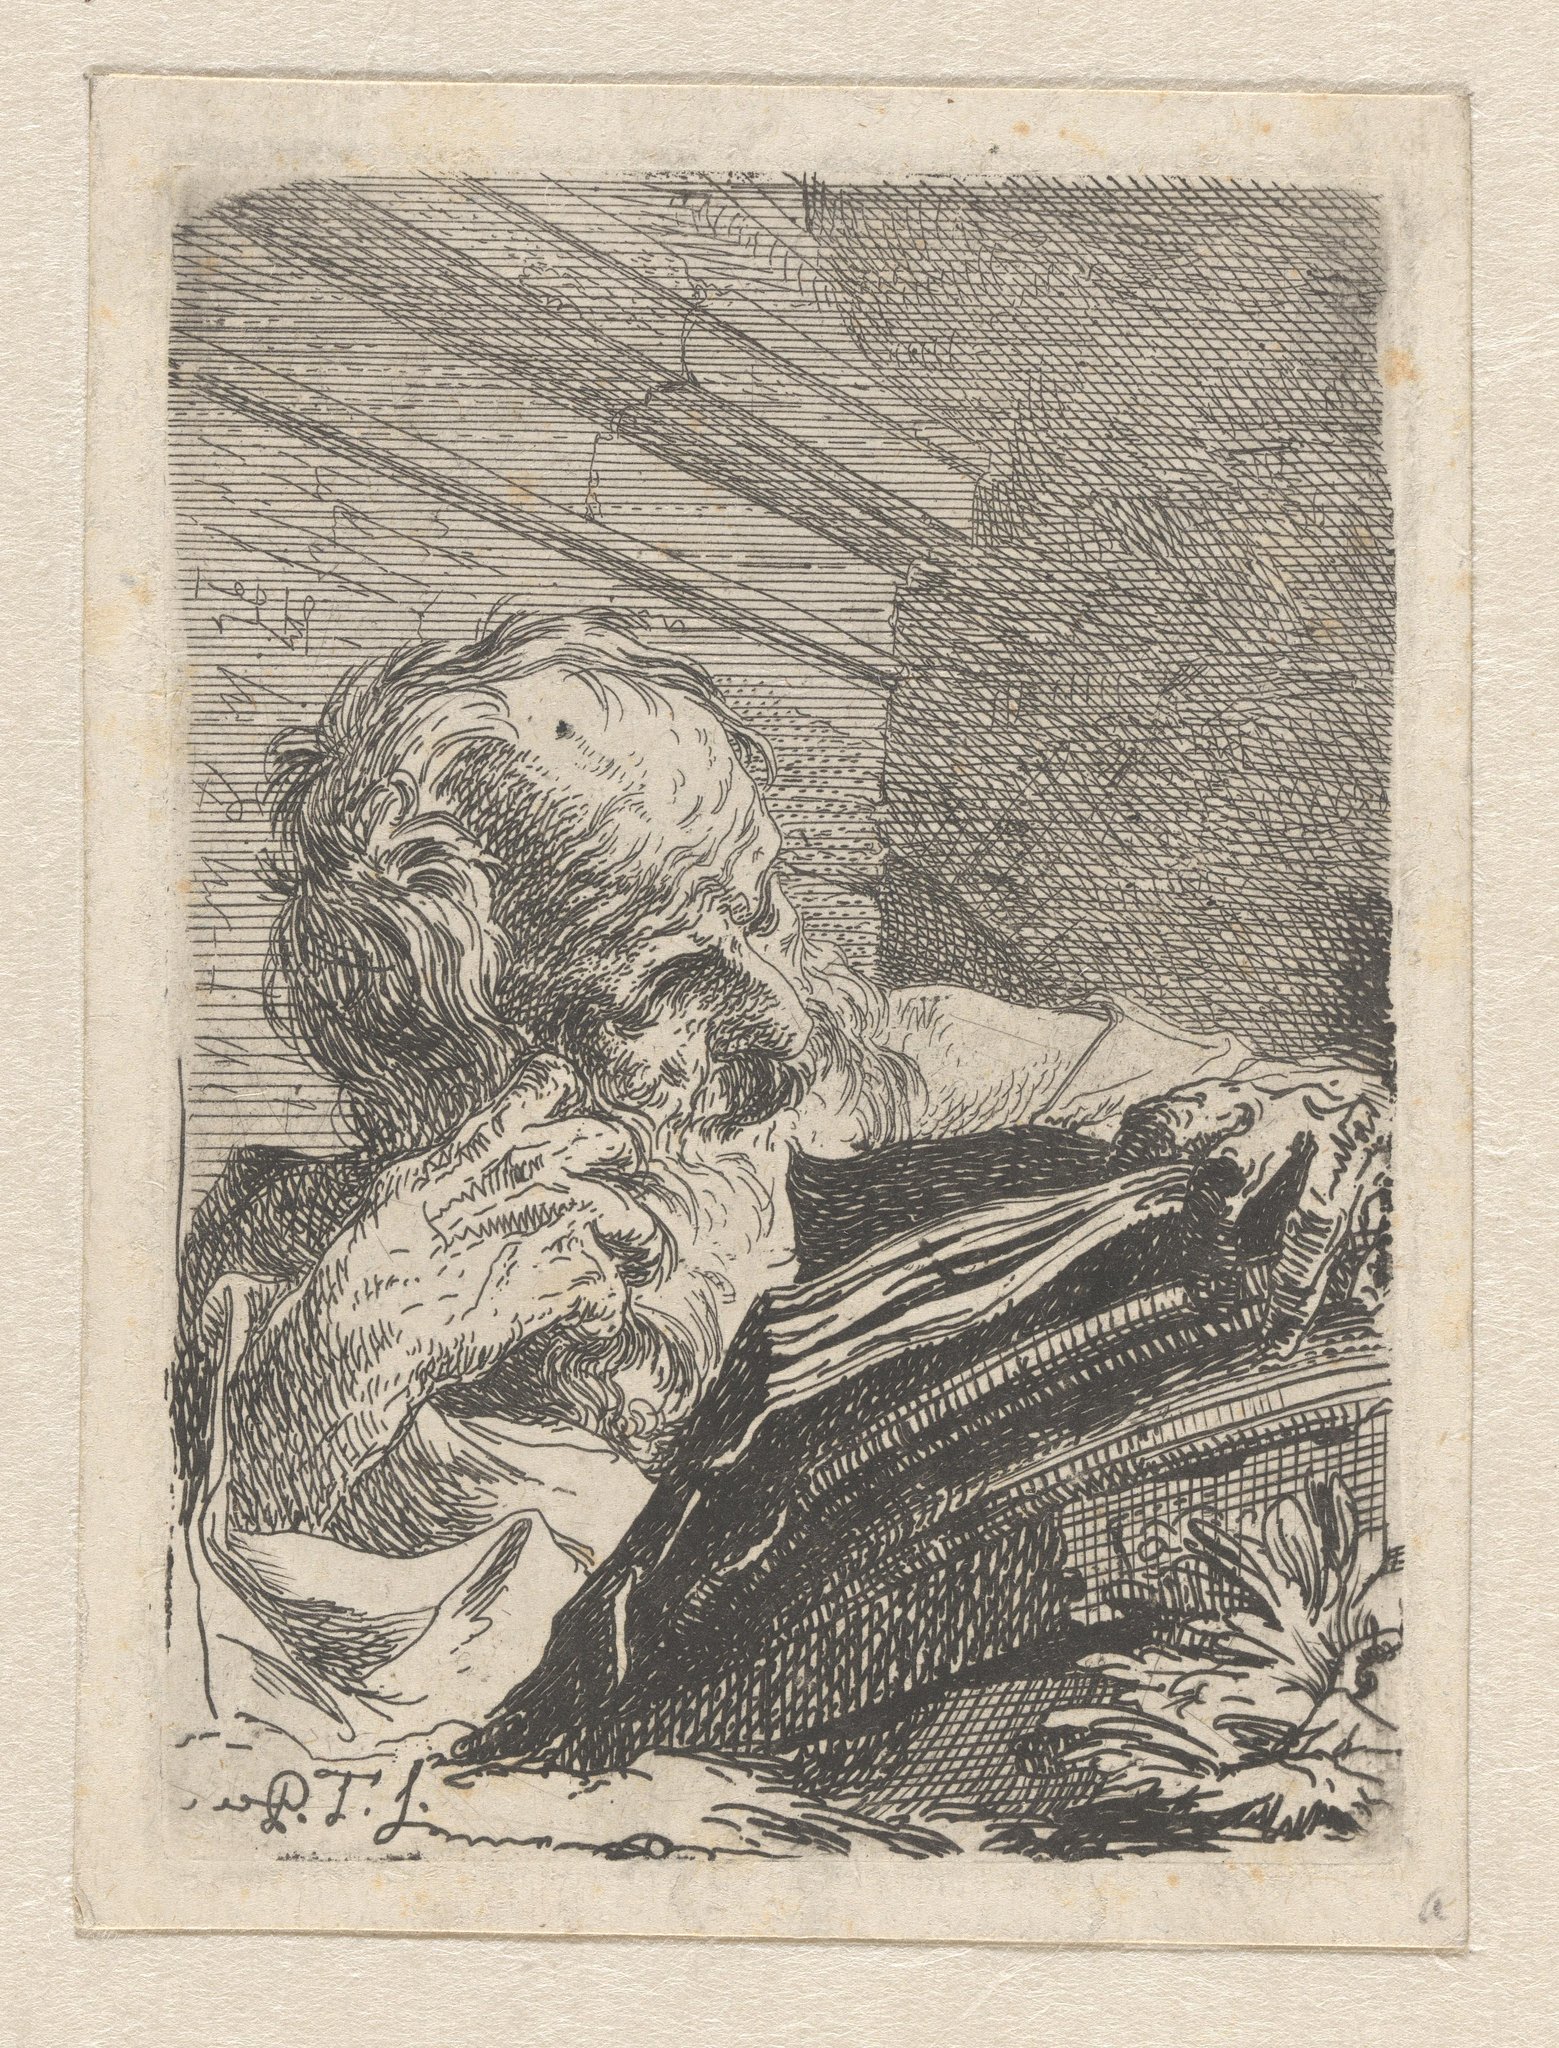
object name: print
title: Buste van een lezende filosoof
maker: paul troger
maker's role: print maker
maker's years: 1698-1762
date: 1720-1730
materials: ink, paper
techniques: etching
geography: vienna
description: Buste van een oude, bebaarde man, lezend in een boek. Met zijn ondekin is hij voorgesteld in de houding van de melancholicus. Vanwege de klassieke architectuur in de achtergrond laat de figuur zich waarschijnlijk duiden als een antieke filosoof, eerder dan als Hieronymus of Johannes de Doper, zoals hij ook wel is geïdentificeerd.